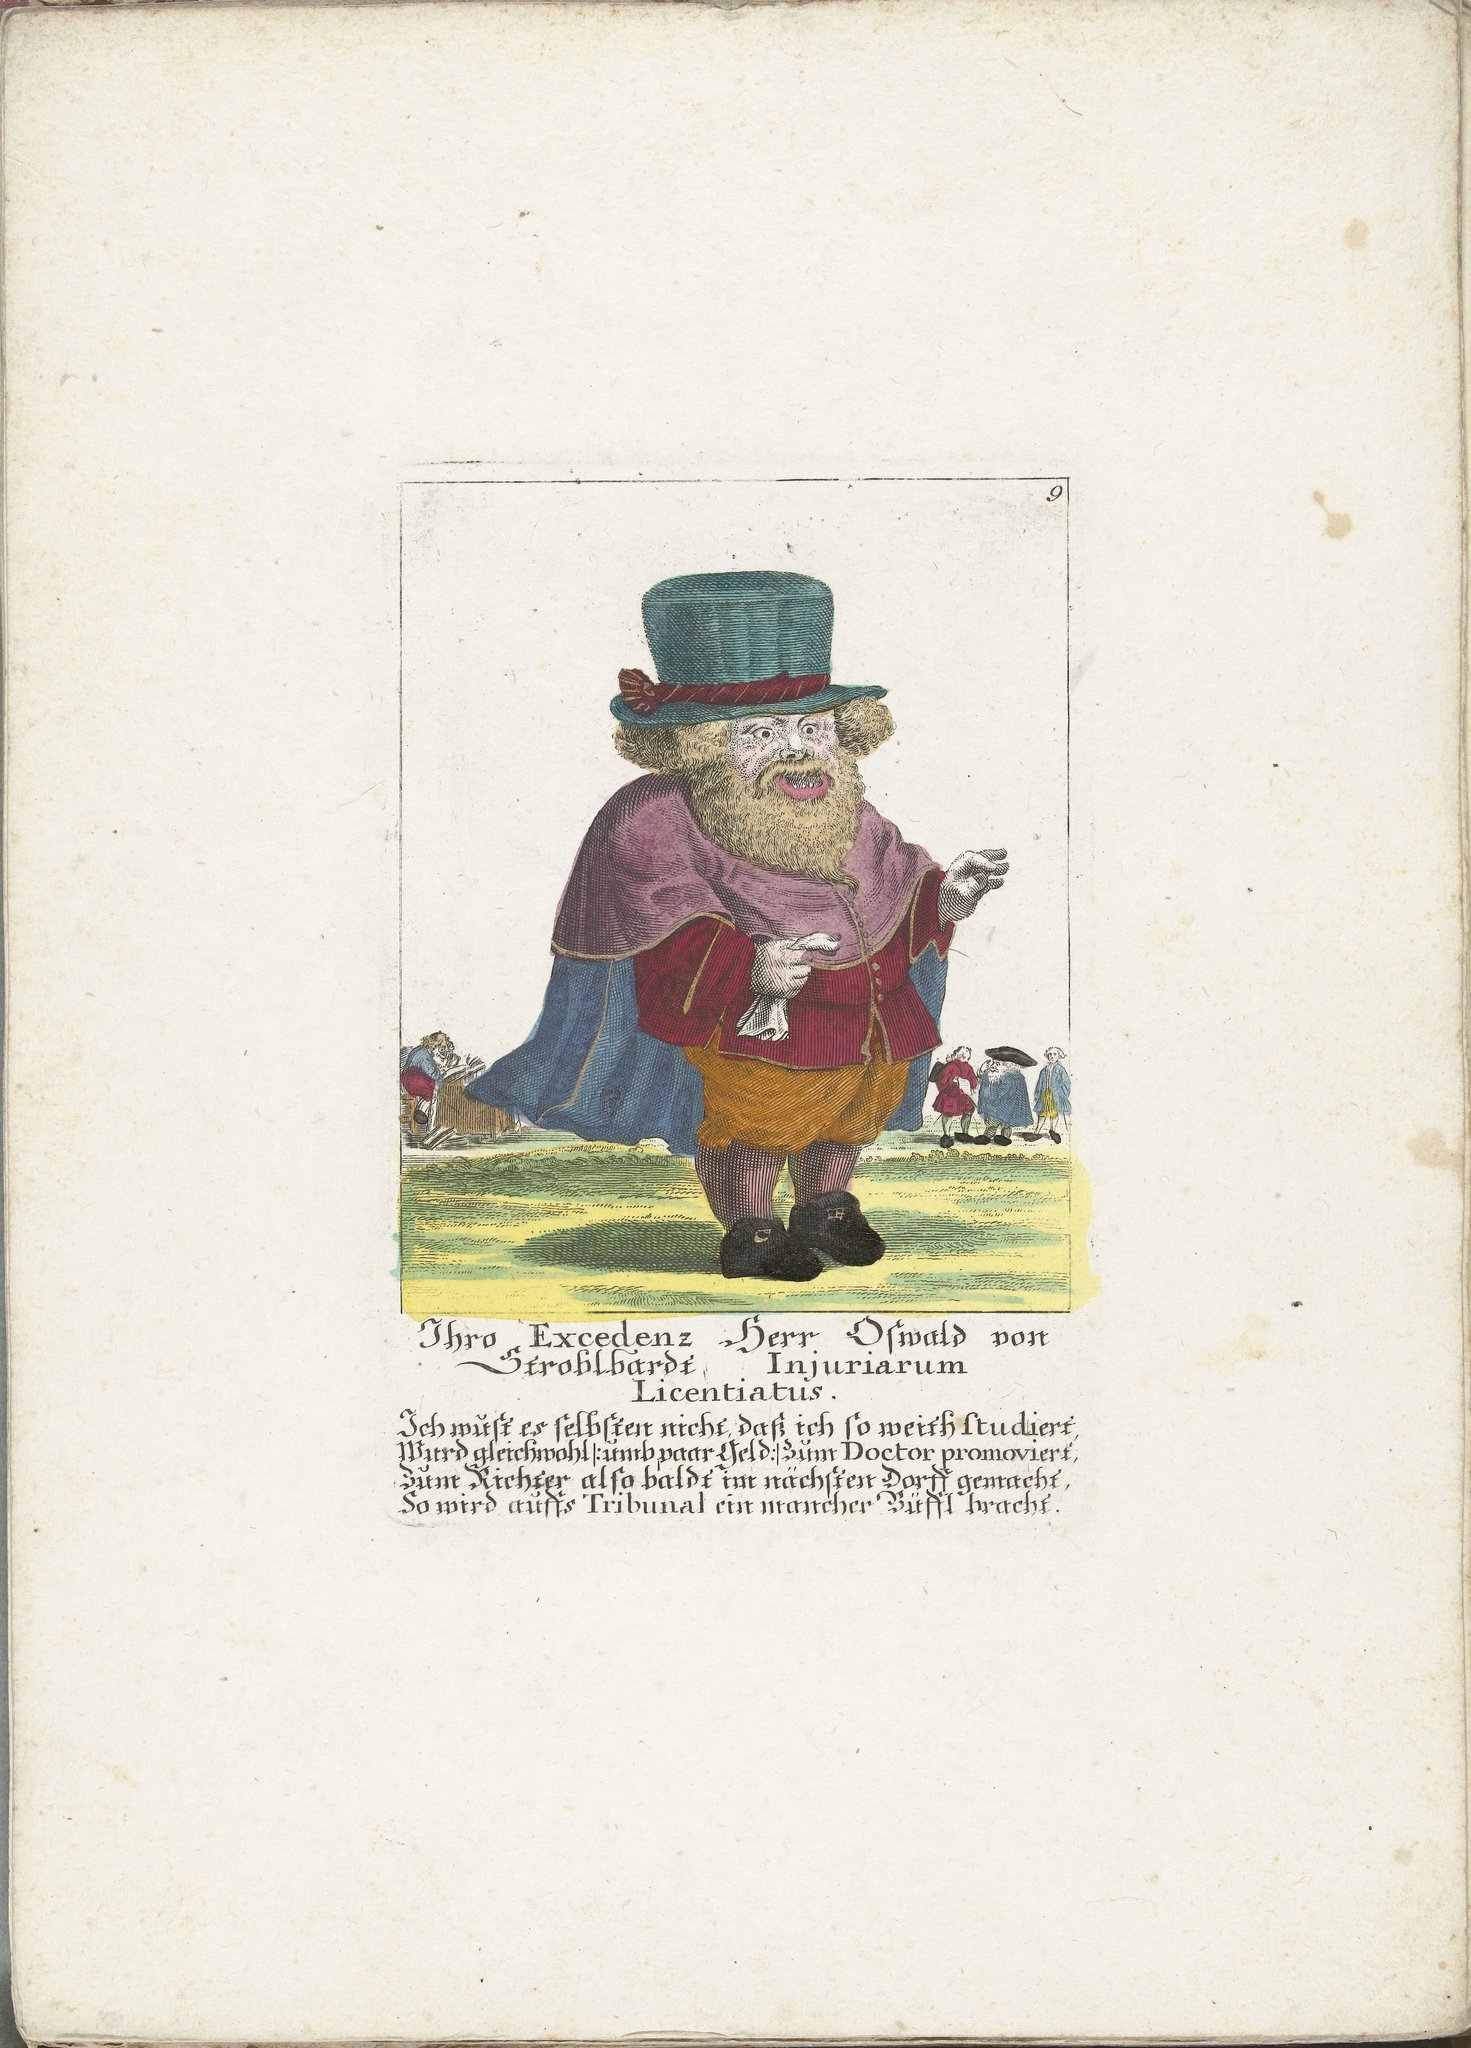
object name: print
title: Il Callotto resurcitato oder Neu eingerichtes Zwerchen Cabinet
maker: martin engelbrecht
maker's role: print maker, publisher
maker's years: 1684-1756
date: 1705-1715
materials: paper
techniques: engraving, etching, hand coloring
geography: augsburg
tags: caricatures (human types), little people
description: De kleine mens Oswald van Stroblbardt. In het onderschrift onder de titel een vierregelig vers in het Duits. Genummerd rechtsboven: 9. Onderdeel van een losbladige uitgave uit ca. 1710 van een serie karikaturen van kleine mensen, bekend als Het Dwergentooneel.